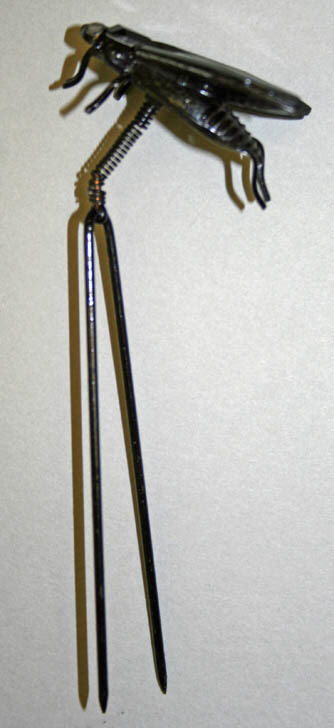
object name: hairpin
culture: american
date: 1870-1879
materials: glass, metal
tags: insects